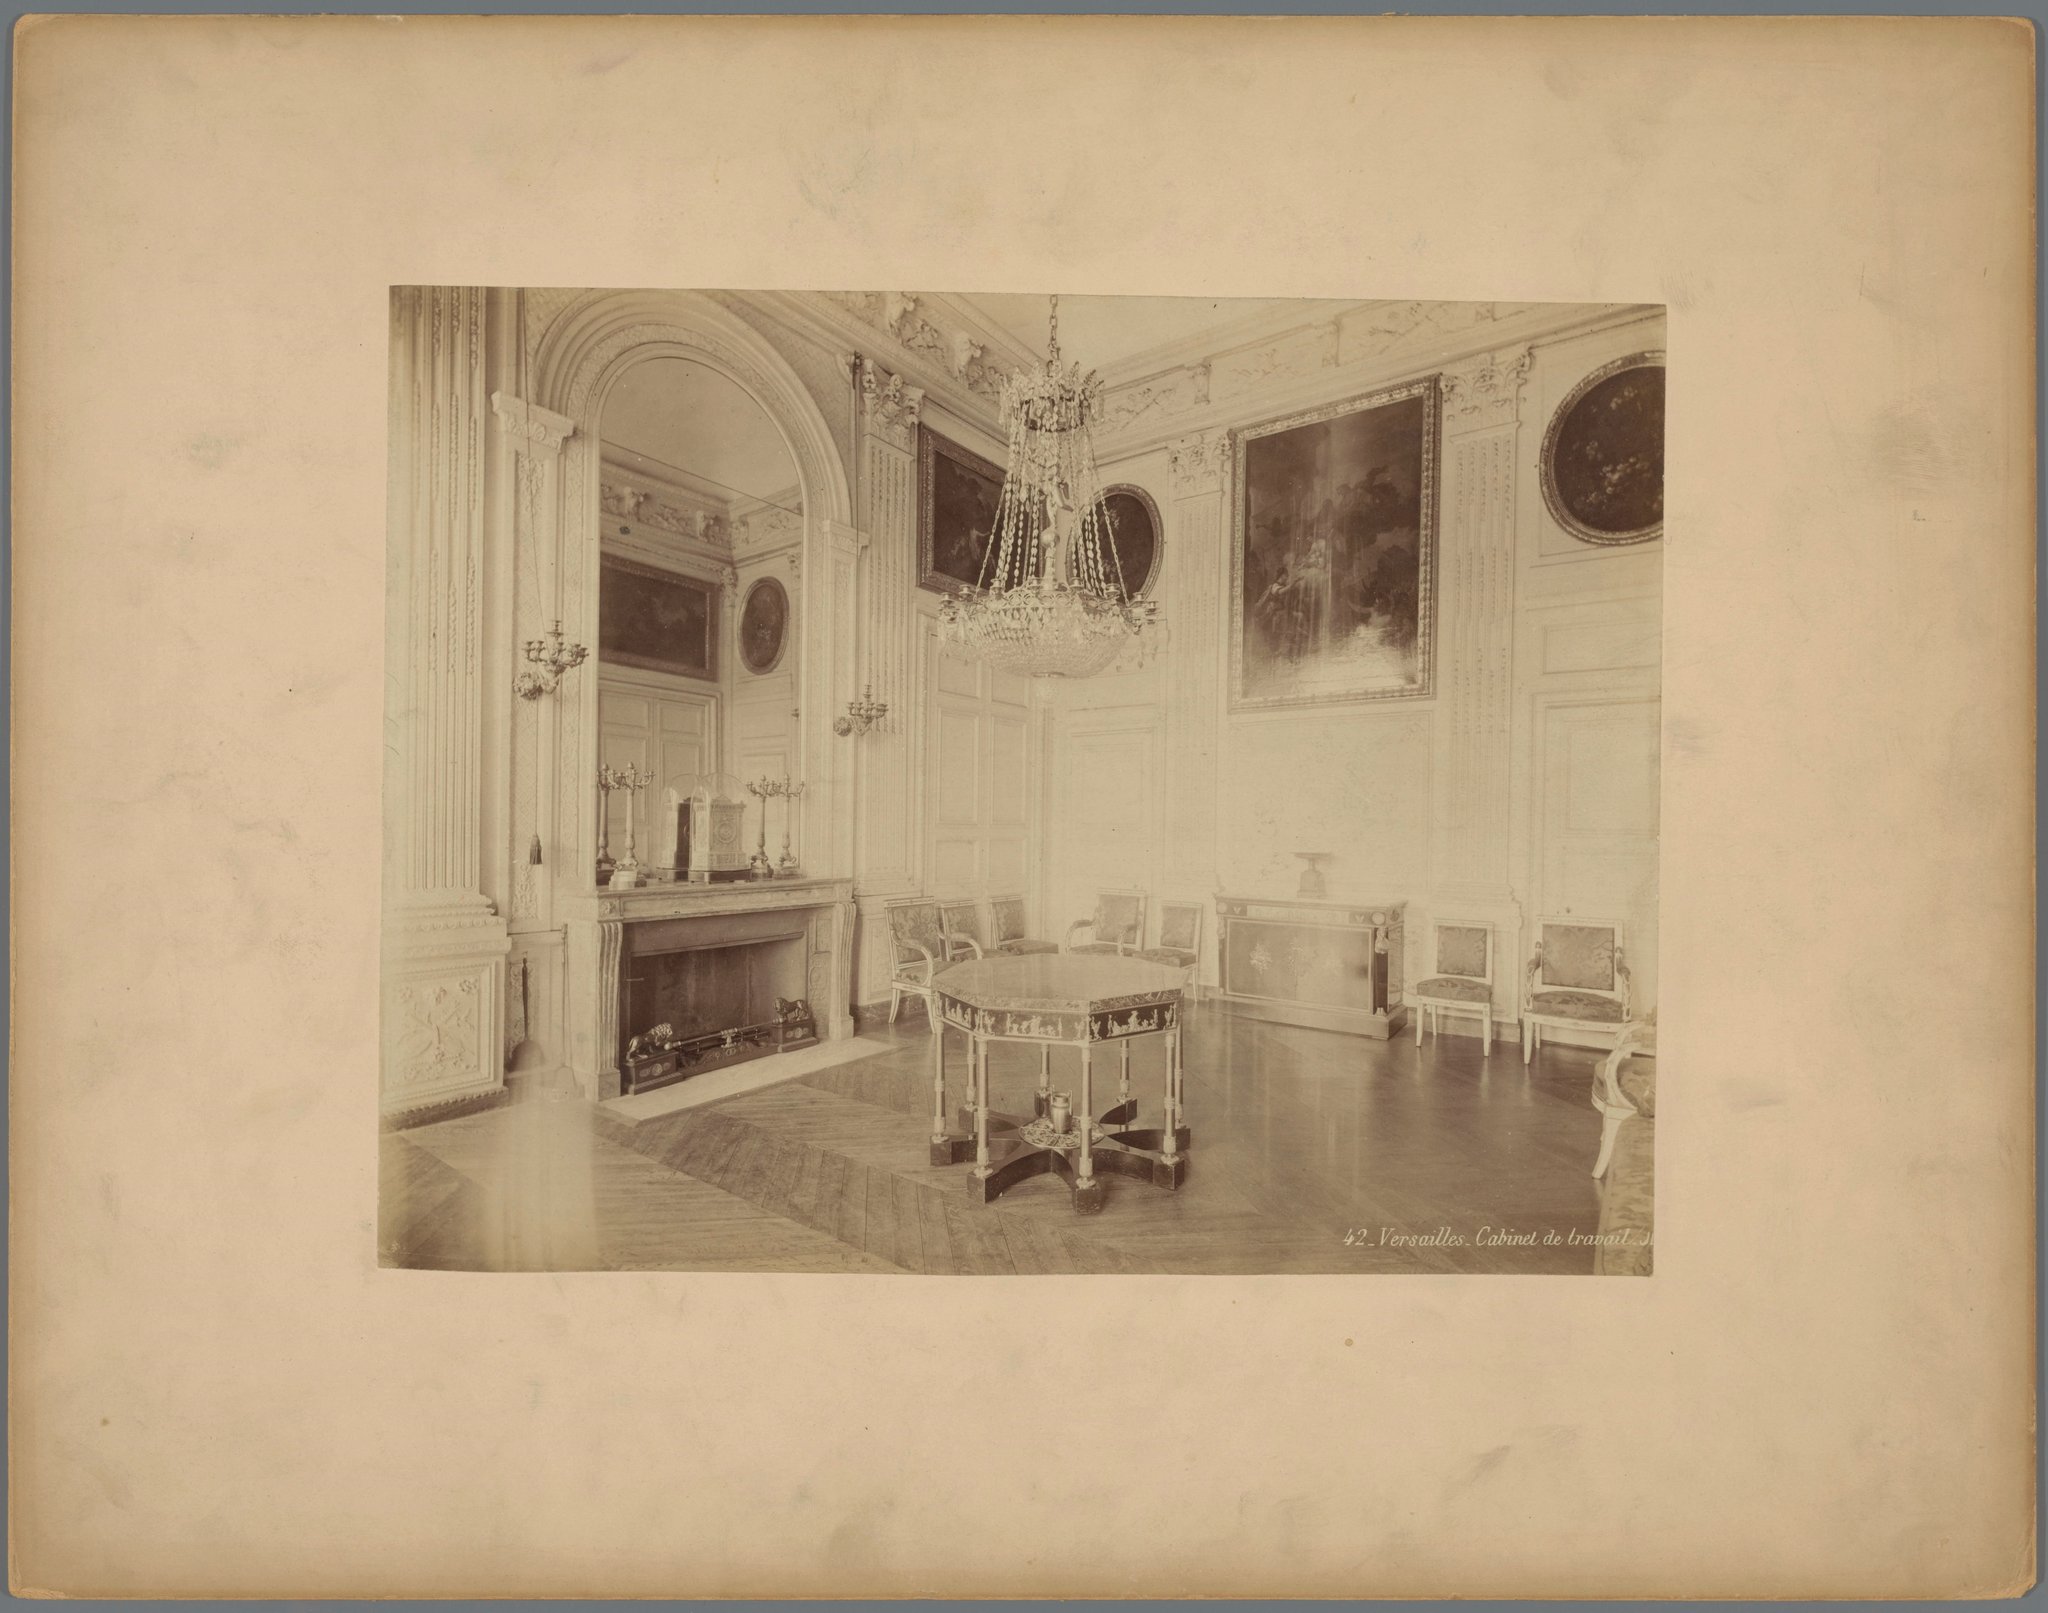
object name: photograph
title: Versailles. Chambre de Napolèon 1er (Gd. Trianon)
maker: jd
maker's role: fotograaf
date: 1875-1900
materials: cardboard, photographic support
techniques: albumen print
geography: grand trianon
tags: chandelier, candelabrum, palace, interior of the house, bed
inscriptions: number: ‘52’, collector's mark: Lugt 3937